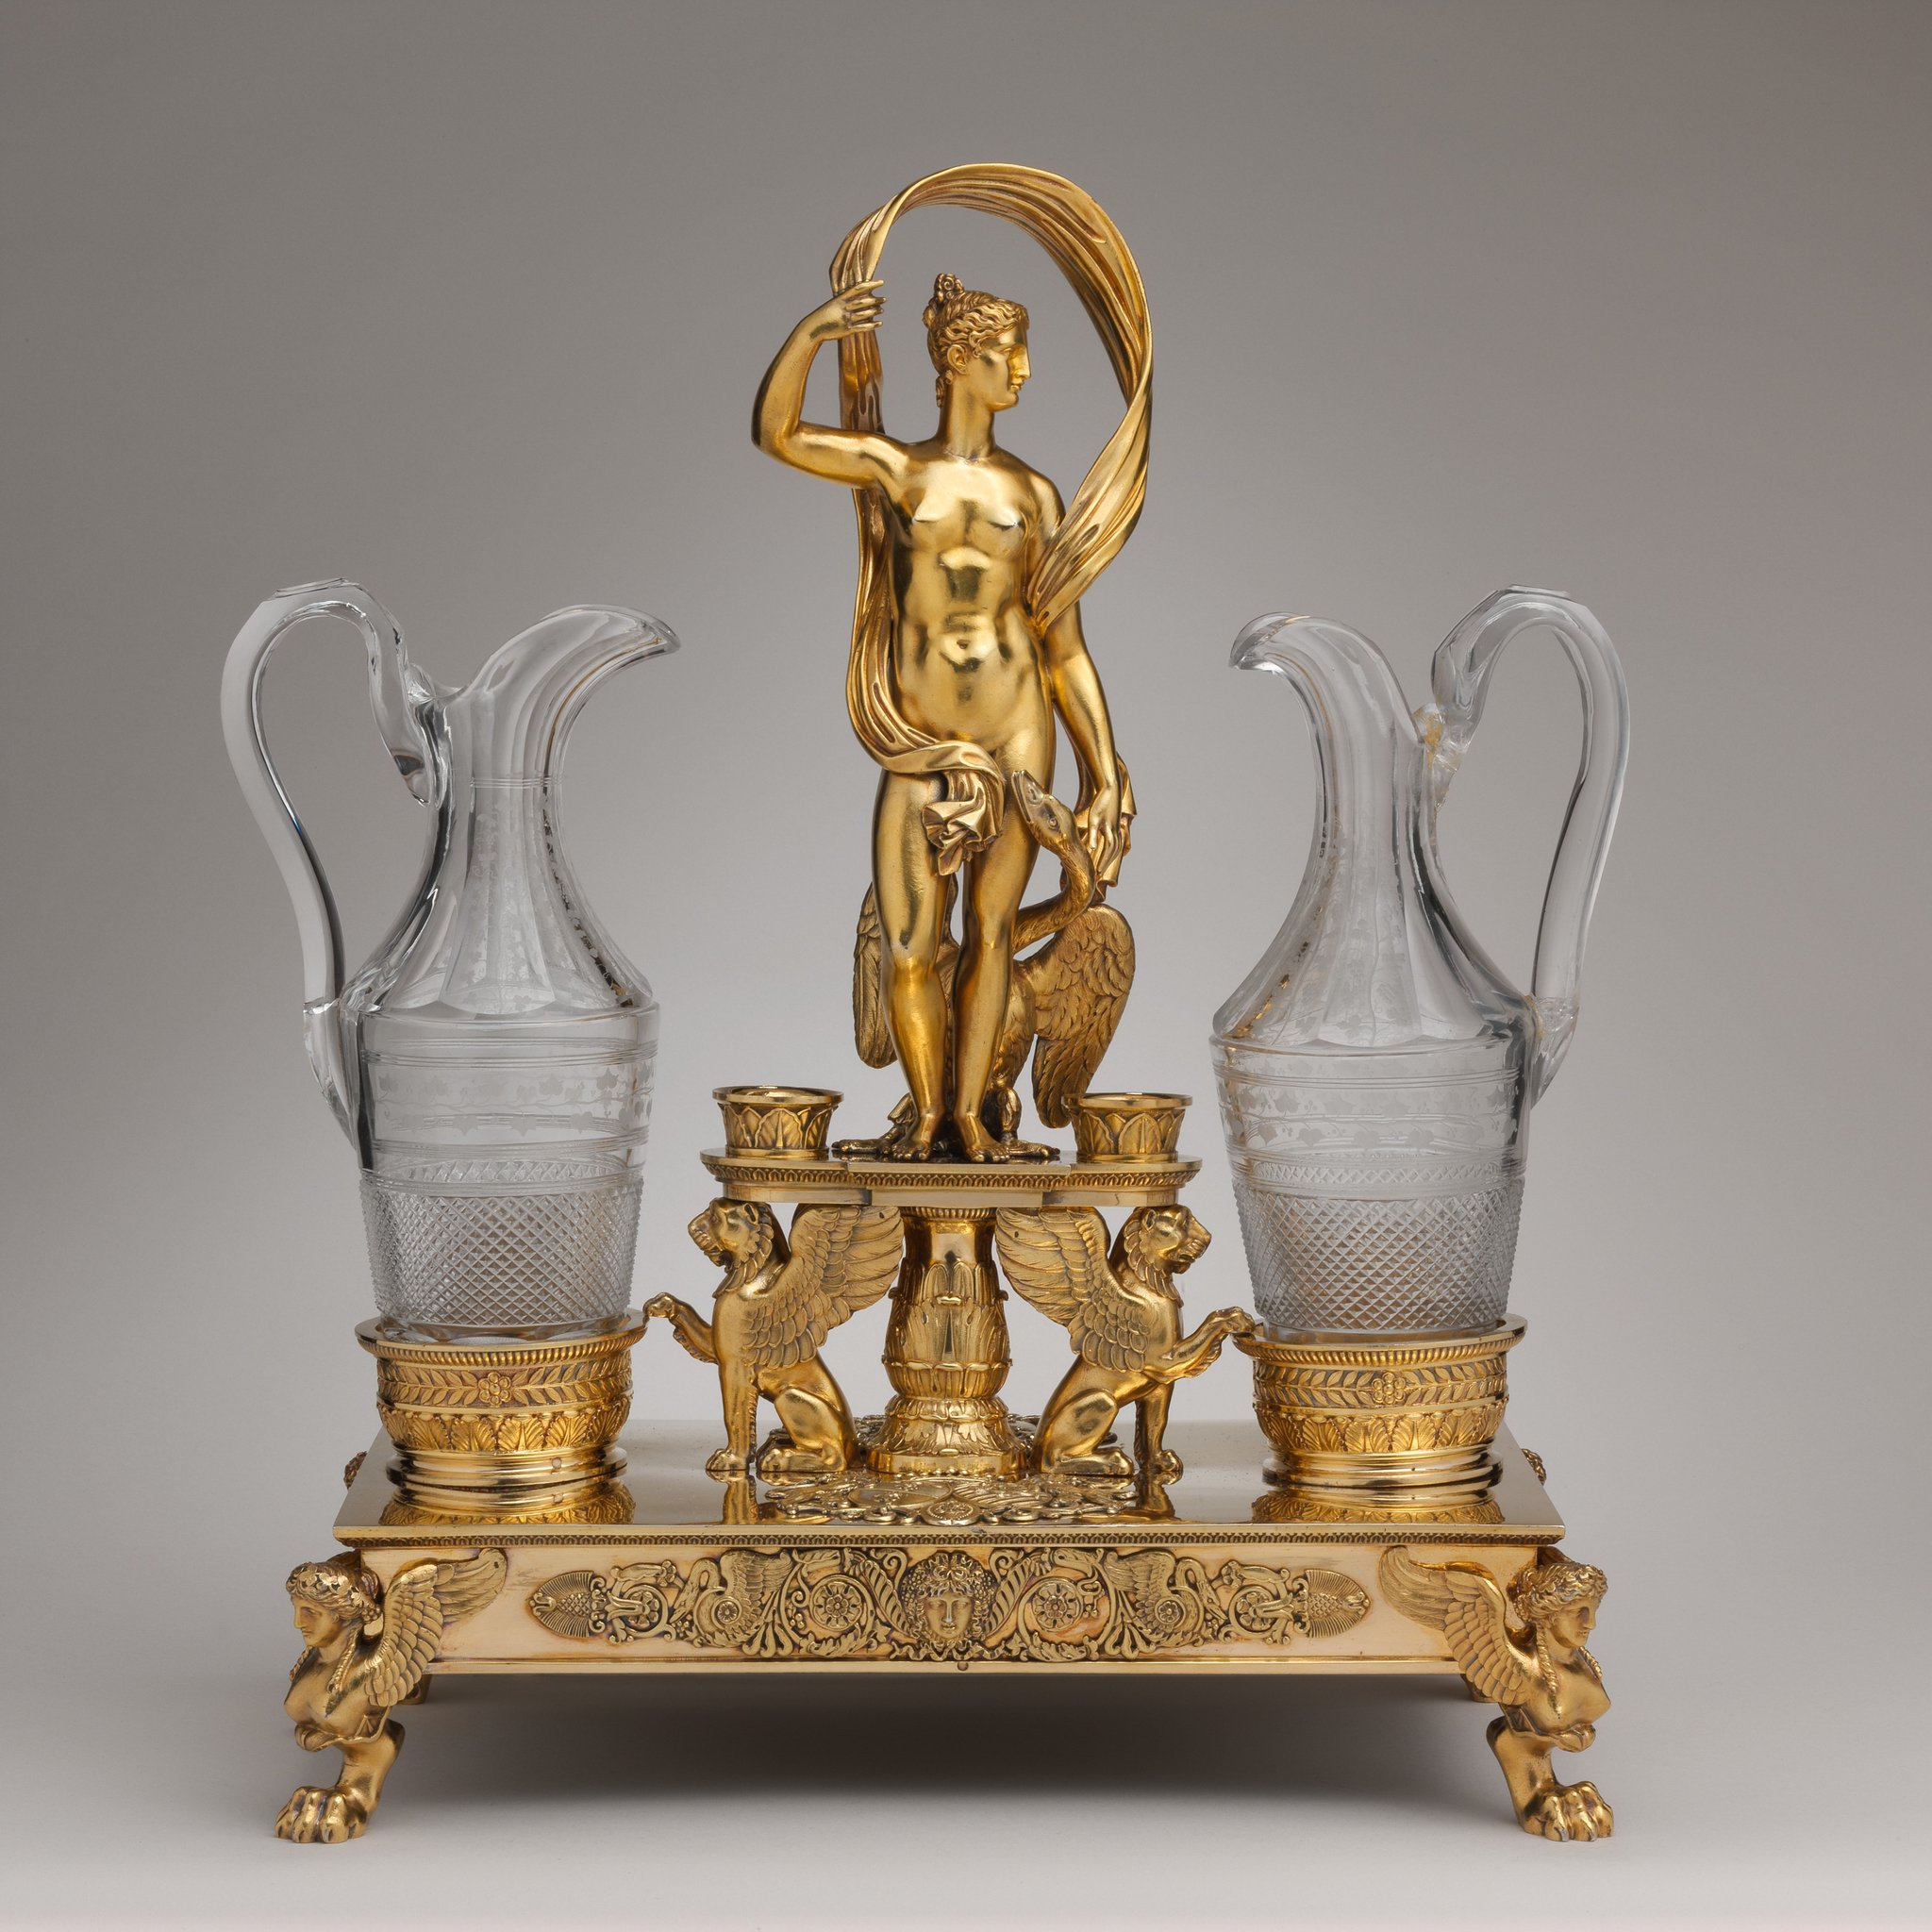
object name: cruet frame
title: Cruet frame (one of a pair)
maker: jean-baptiste-claude odiot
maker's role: maker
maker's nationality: french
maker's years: 1763-1850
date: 1817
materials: glass, silver gilt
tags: leda,swans,lions